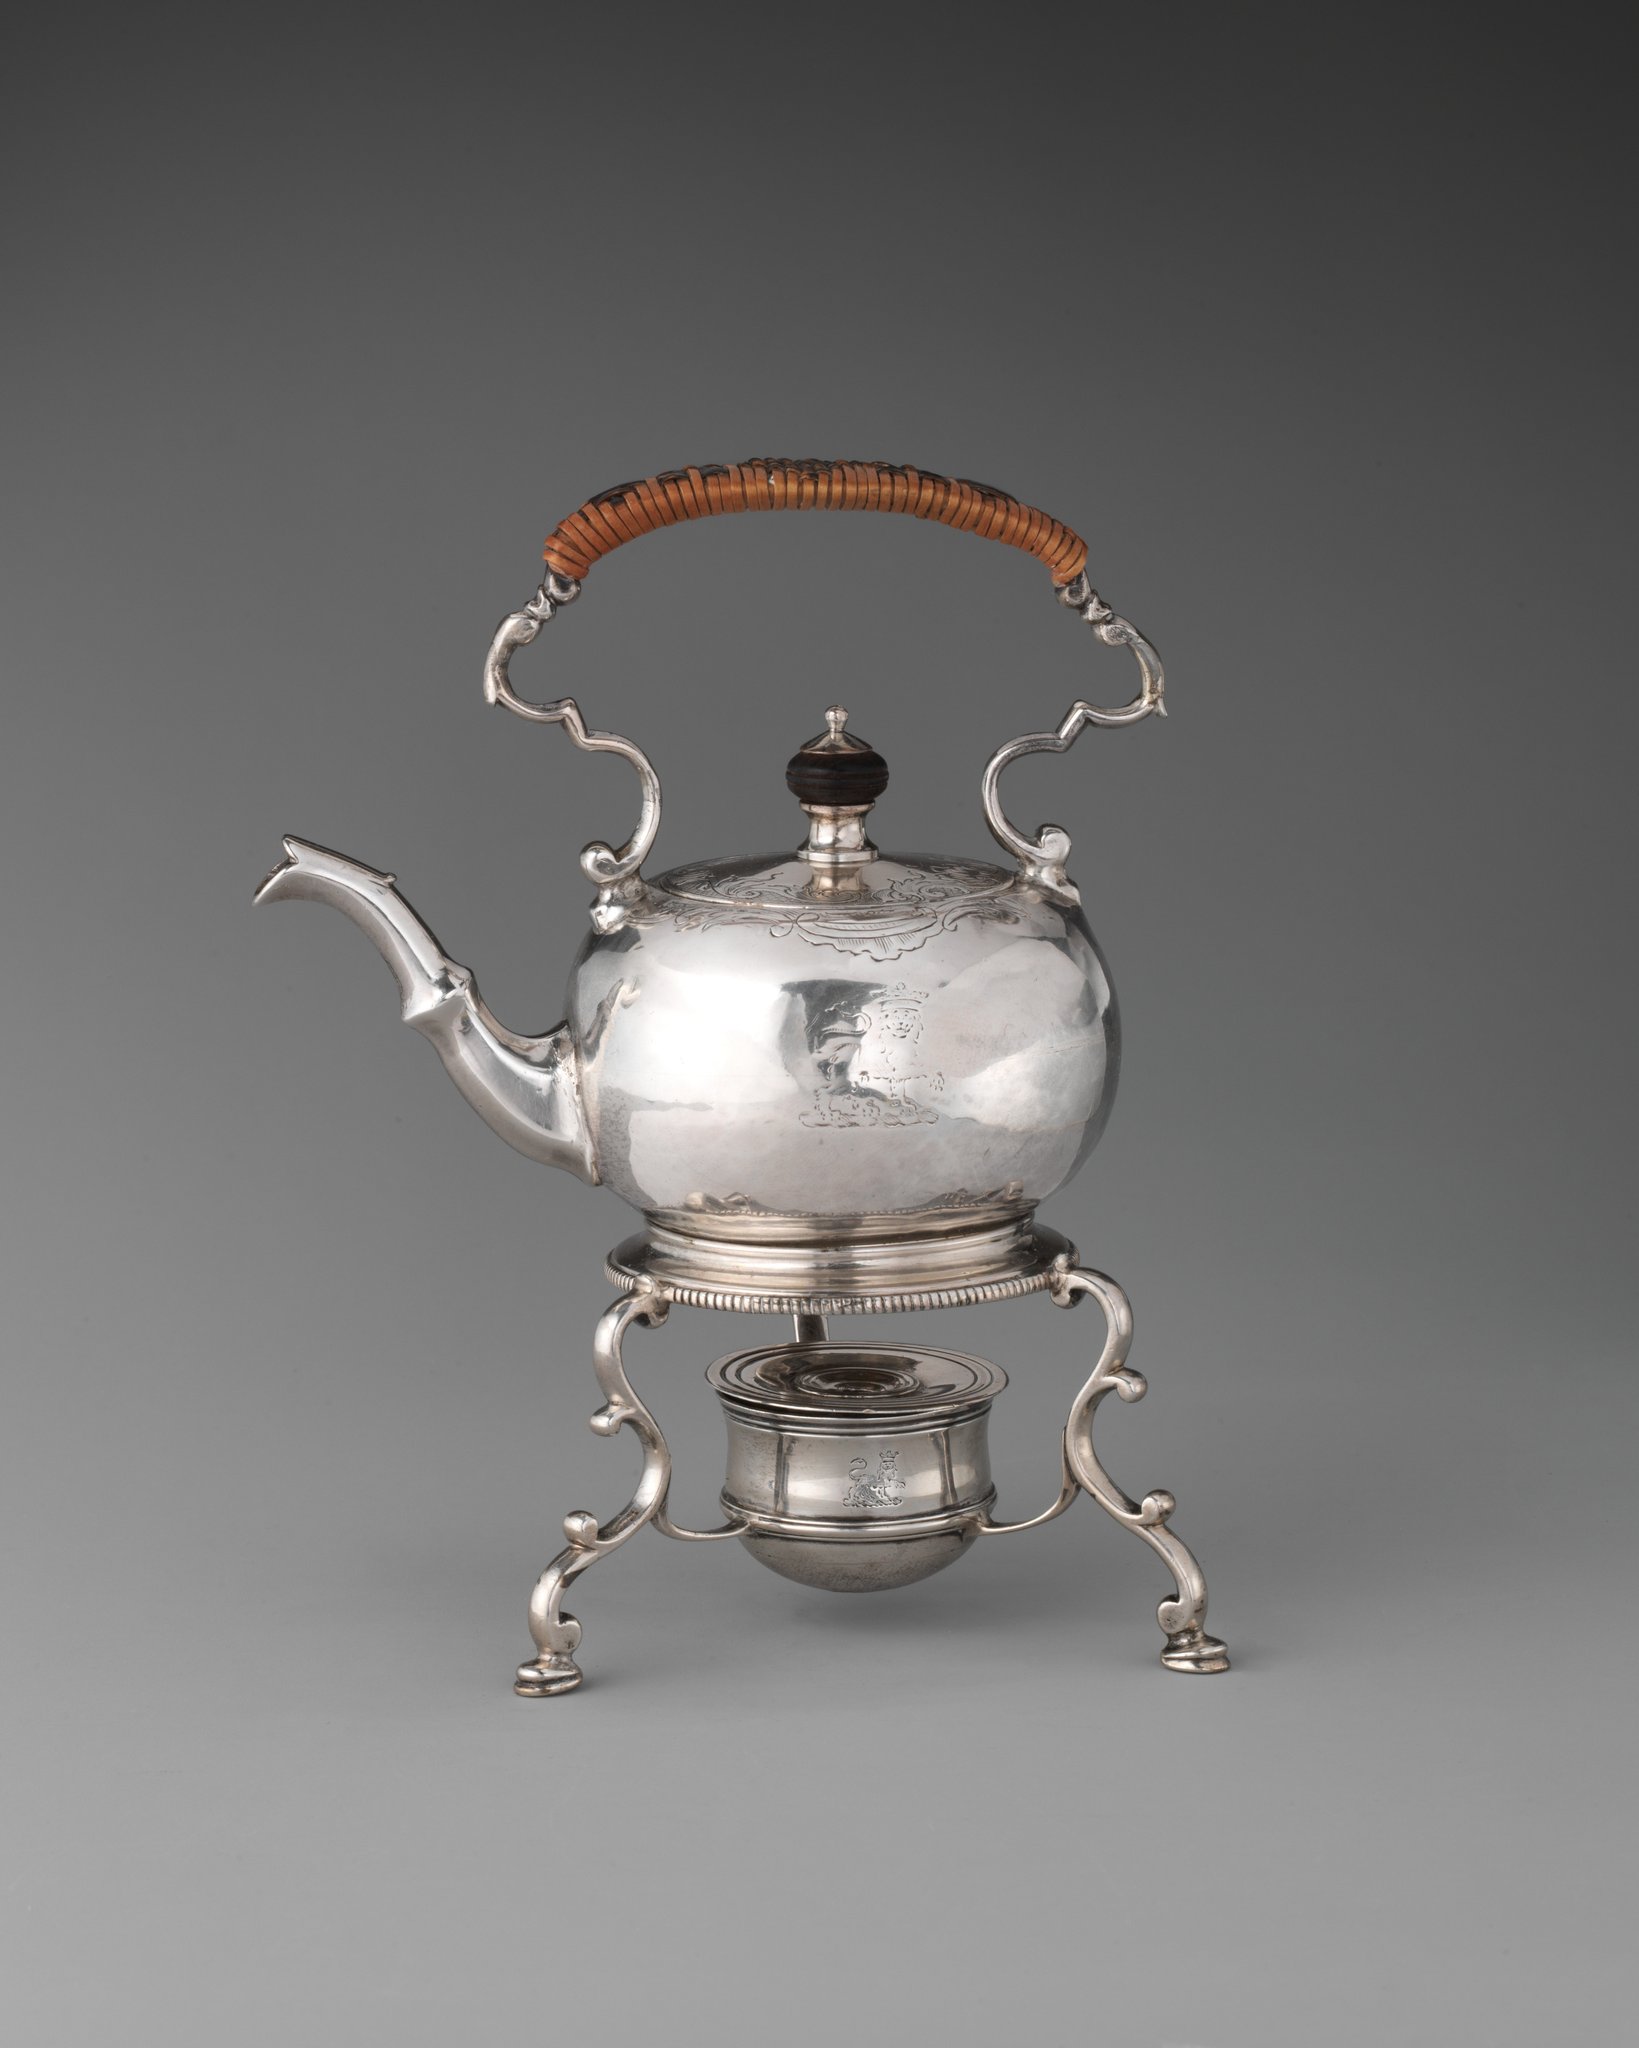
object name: kettle with stand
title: Miniature kettle and stand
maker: john le sage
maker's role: maker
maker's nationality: british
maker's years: 1718-1743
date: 1740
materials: silver, wood